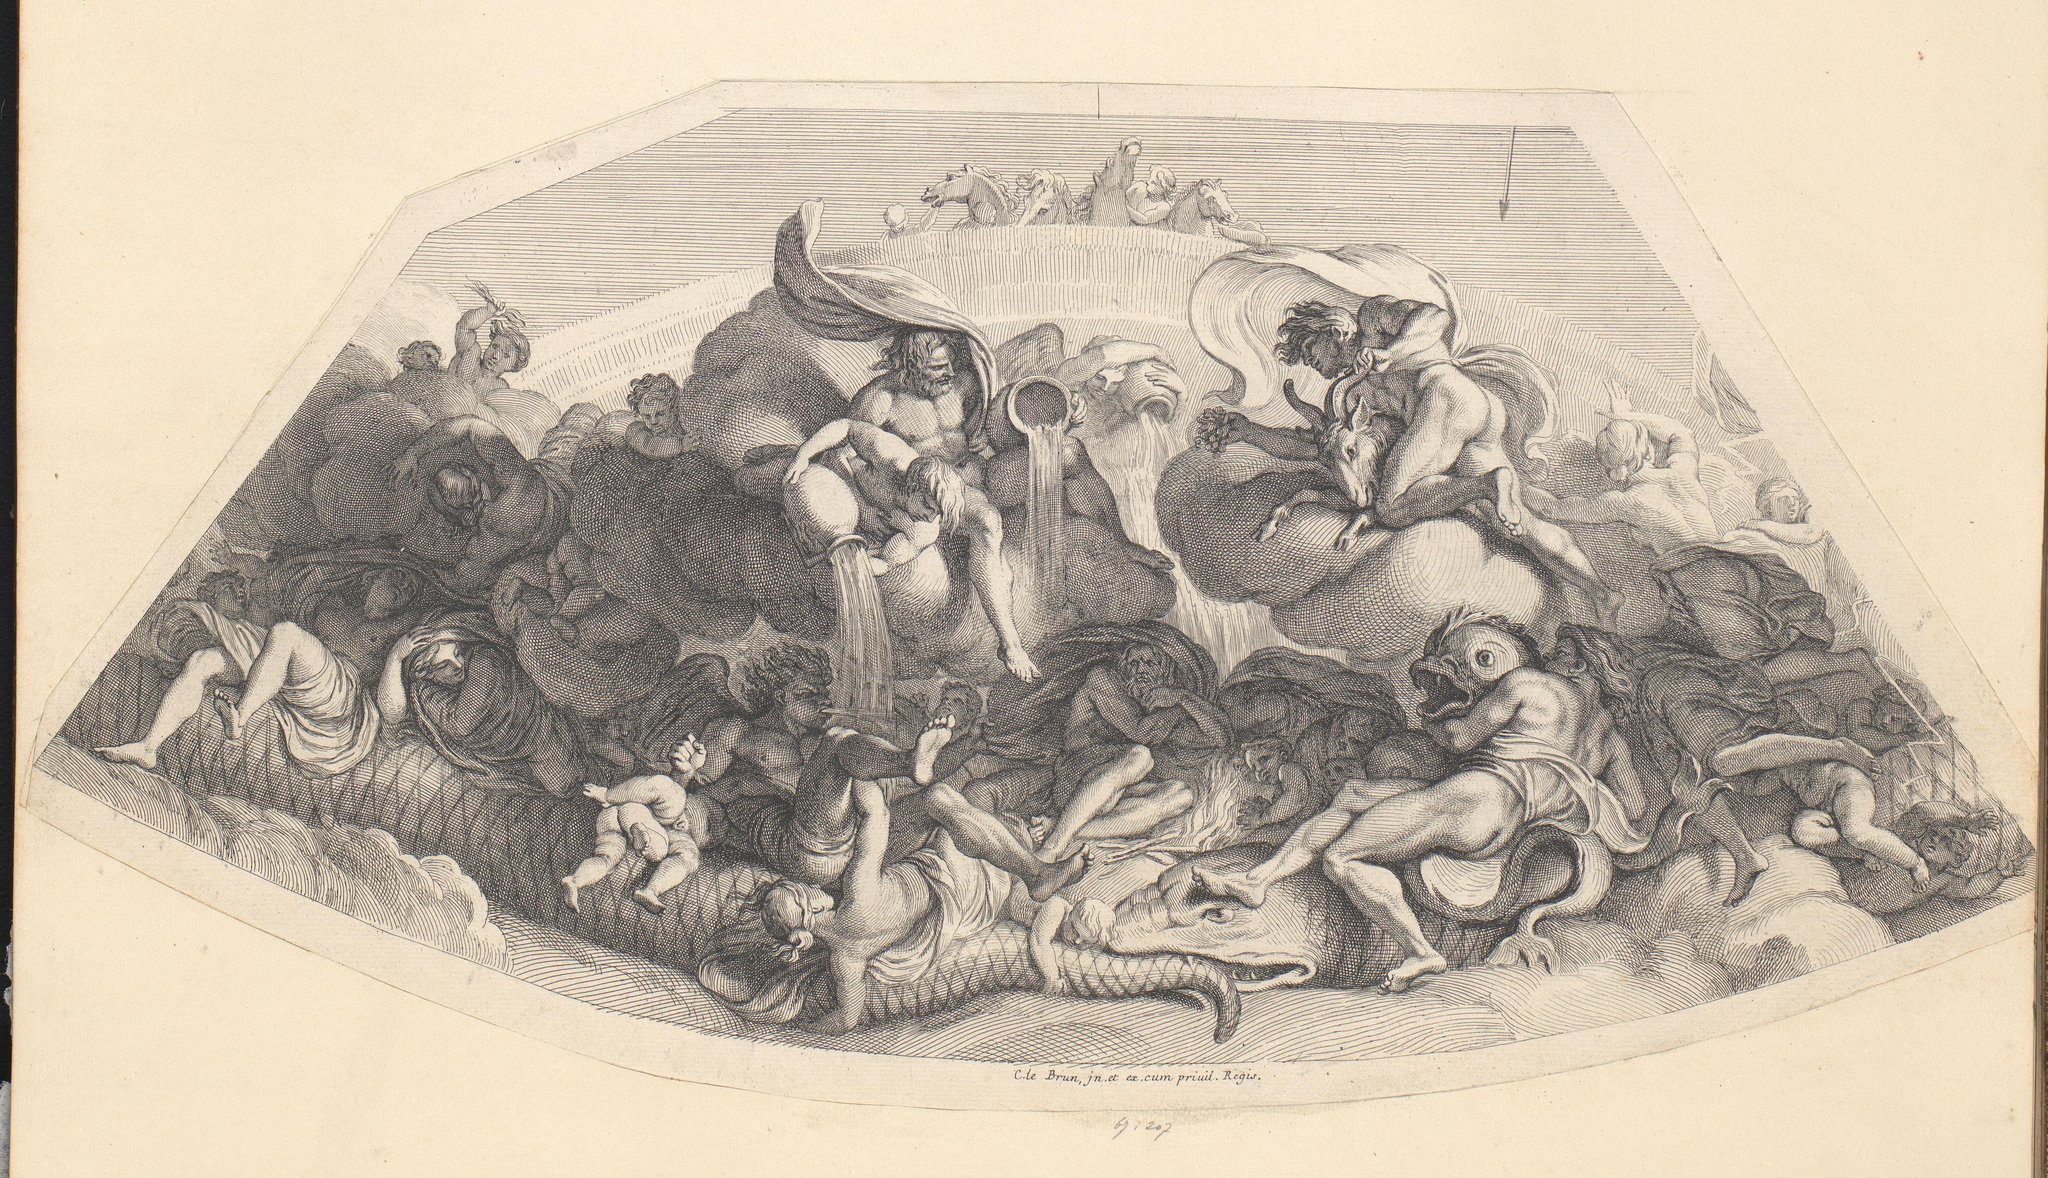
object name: album leaf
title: Werken van Charles le Brun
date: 1681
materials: paper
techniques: engraving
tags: (decorated) ceiling, roman deities, and foreign deities included in the classical pantheon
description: Eén van de zes prenten die samen het onwerp vormen voor een nooit uitgevoerd plafond in het kasteel van Vaux-le-Vicomte. Deze prent maakt deel uit van een album.